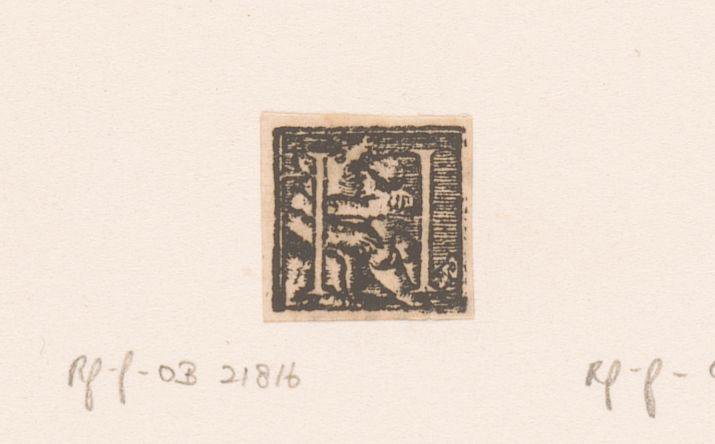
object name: book illustration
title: Versierde initialen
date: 1556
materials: paper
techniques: letterpress printing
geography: zurich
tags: initial, ornament derived from plant forms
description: Prent afkomstig uit: Bibel, die gantze, das ist alle Bücher alts und news Testaments (...). Zürich: Johann Froschauer, 1556.